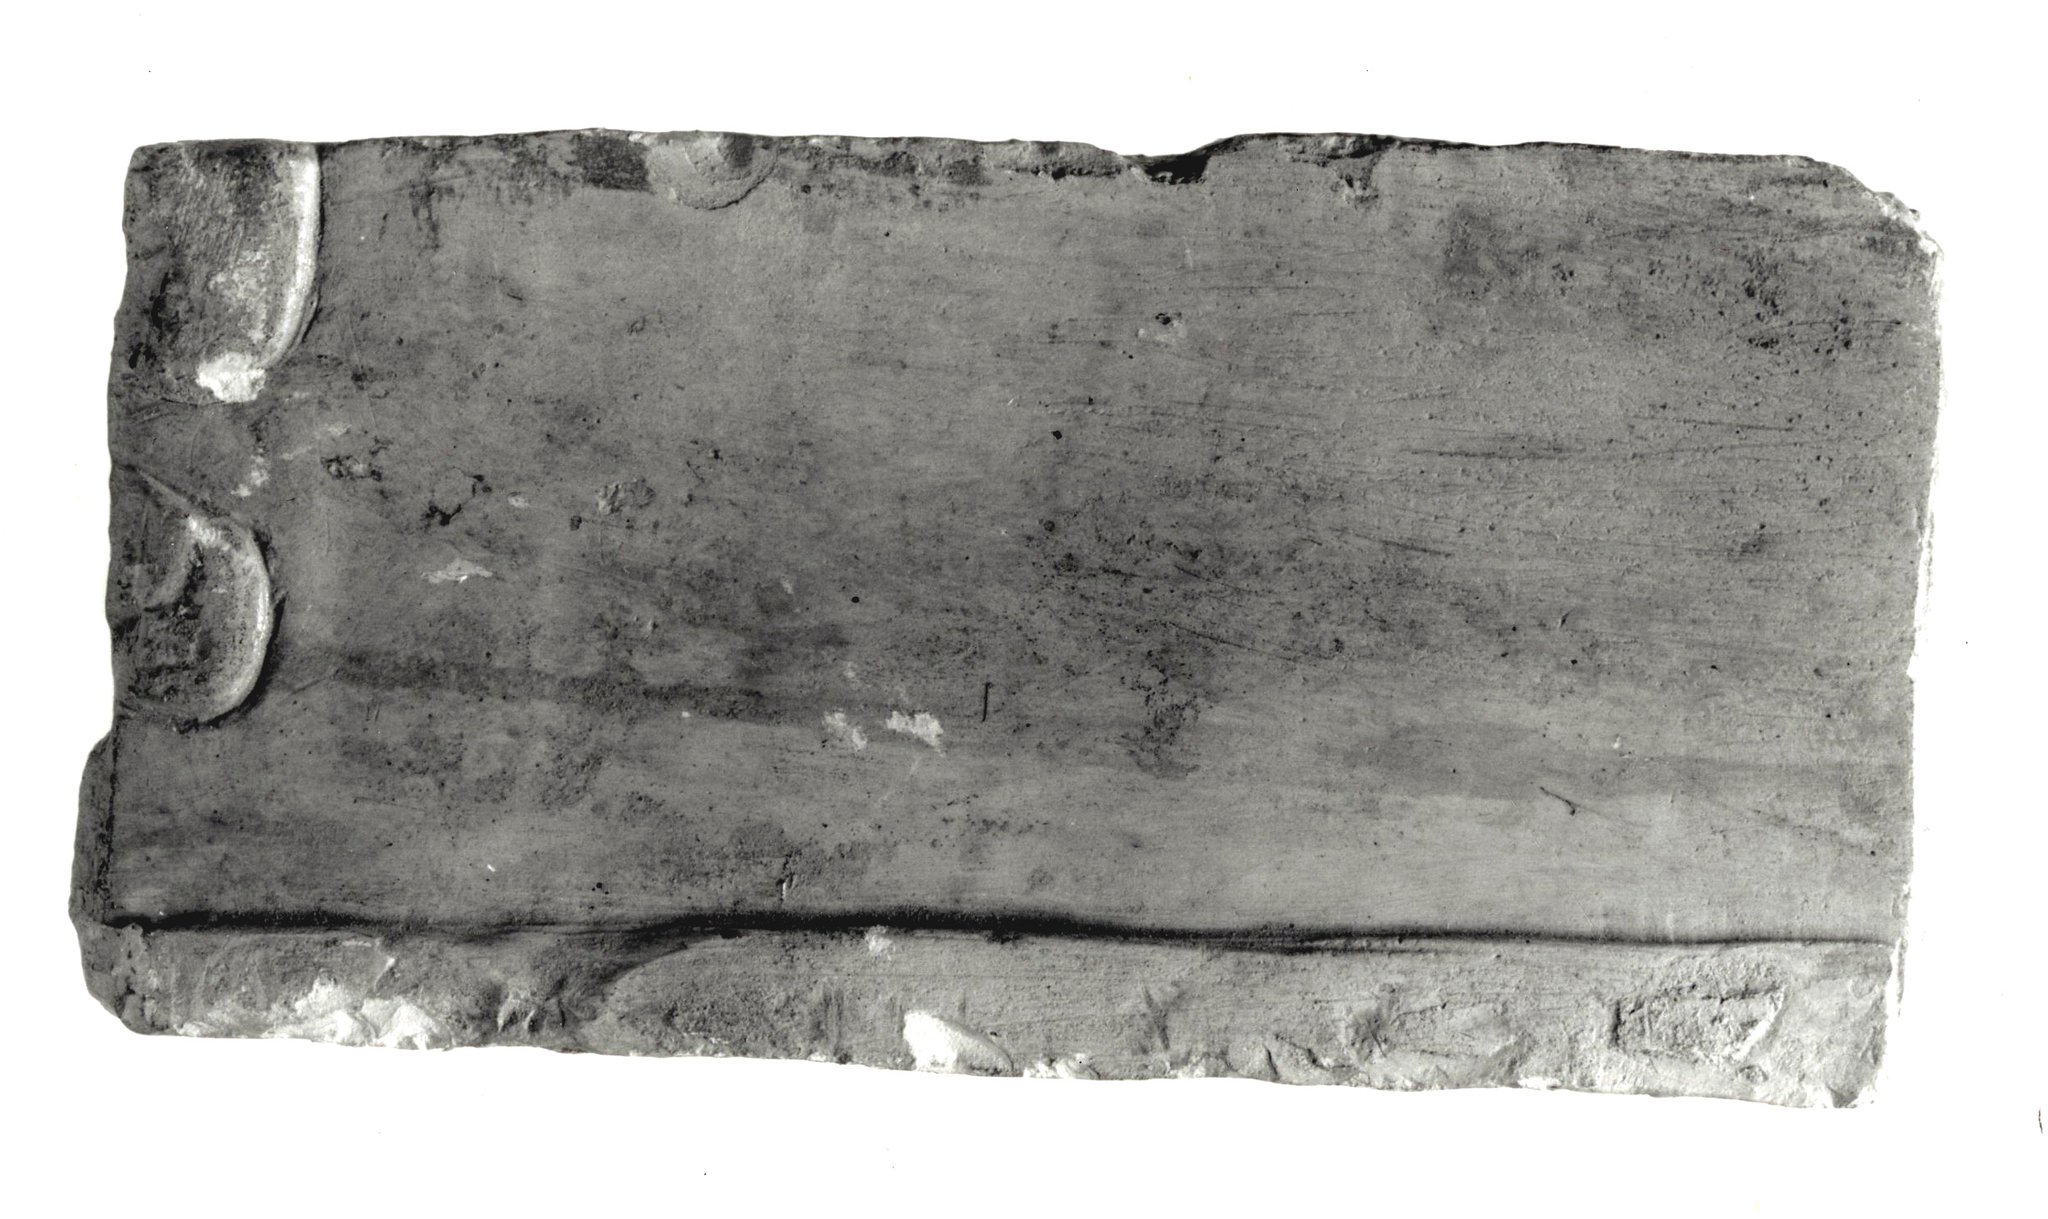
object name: relief, tomb of nespekashuty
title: Raised Relief Fragment with Remains of Offering Figure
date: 664-610 BCE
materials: limestone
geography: egypt